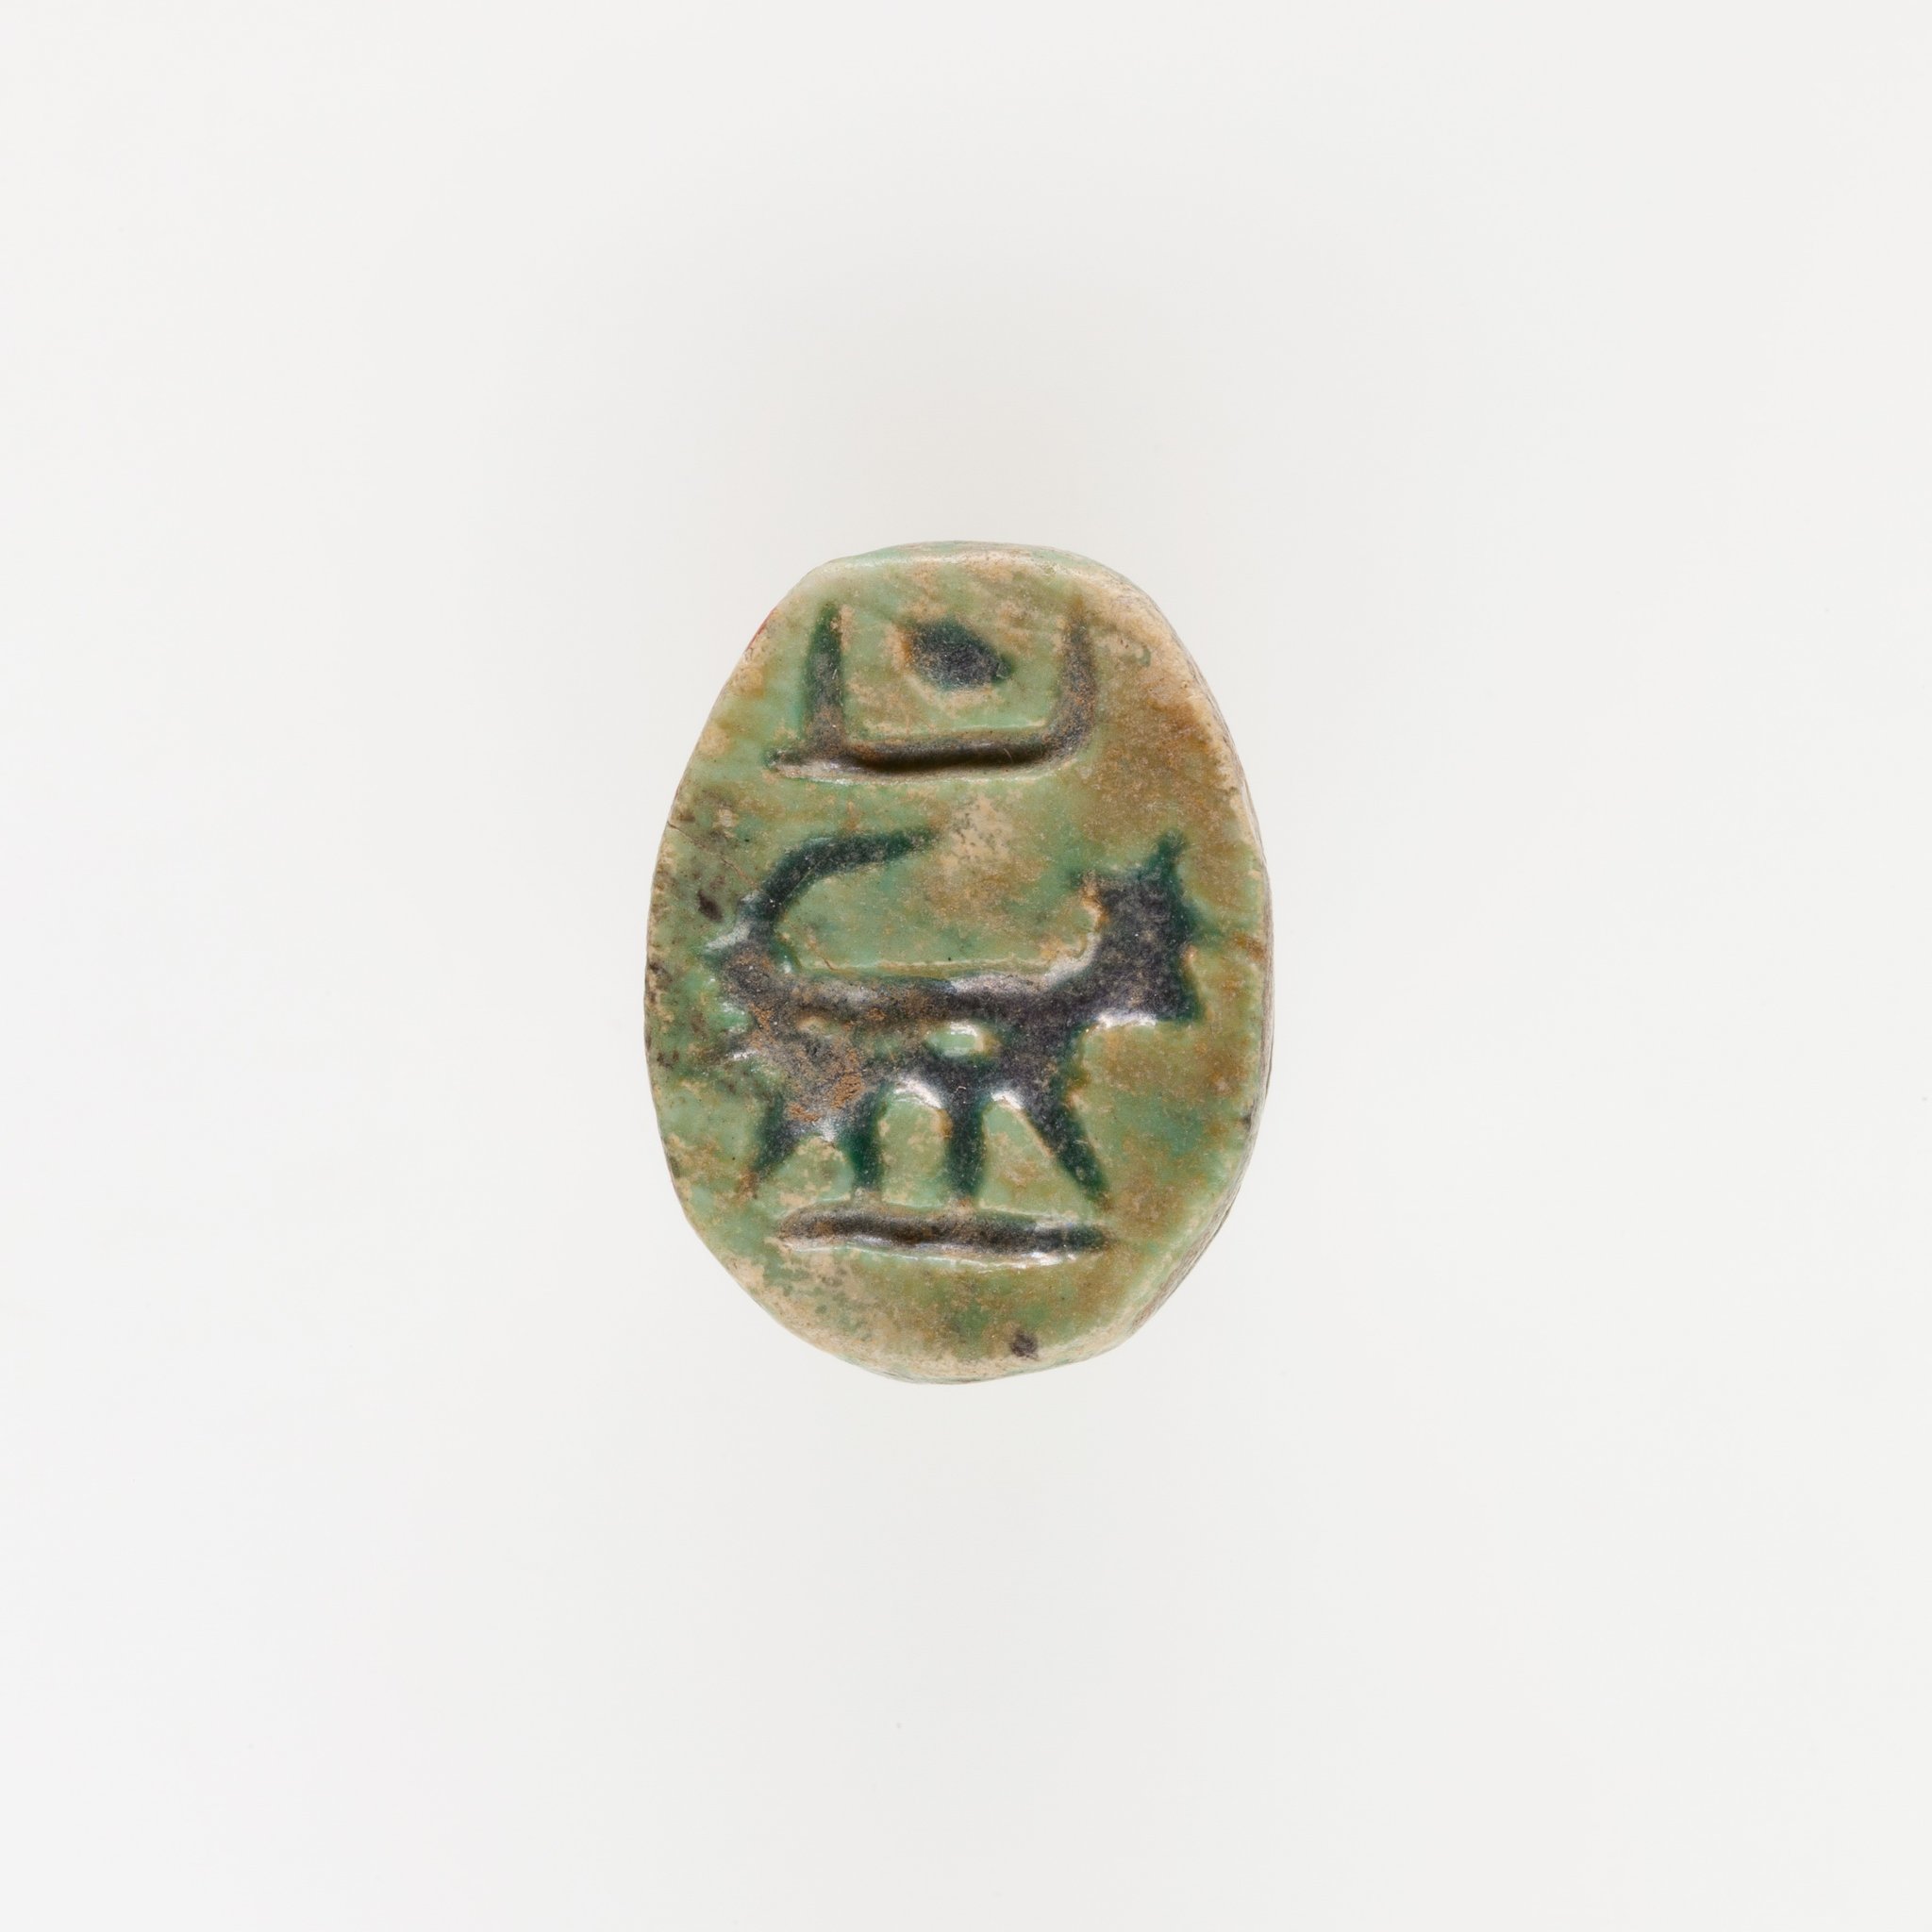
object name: scarab, quadruped, lion, sun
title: Scarab with Quadruped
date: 1186-945 BCE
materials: stone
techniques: glazing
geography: egypt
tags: scarabs